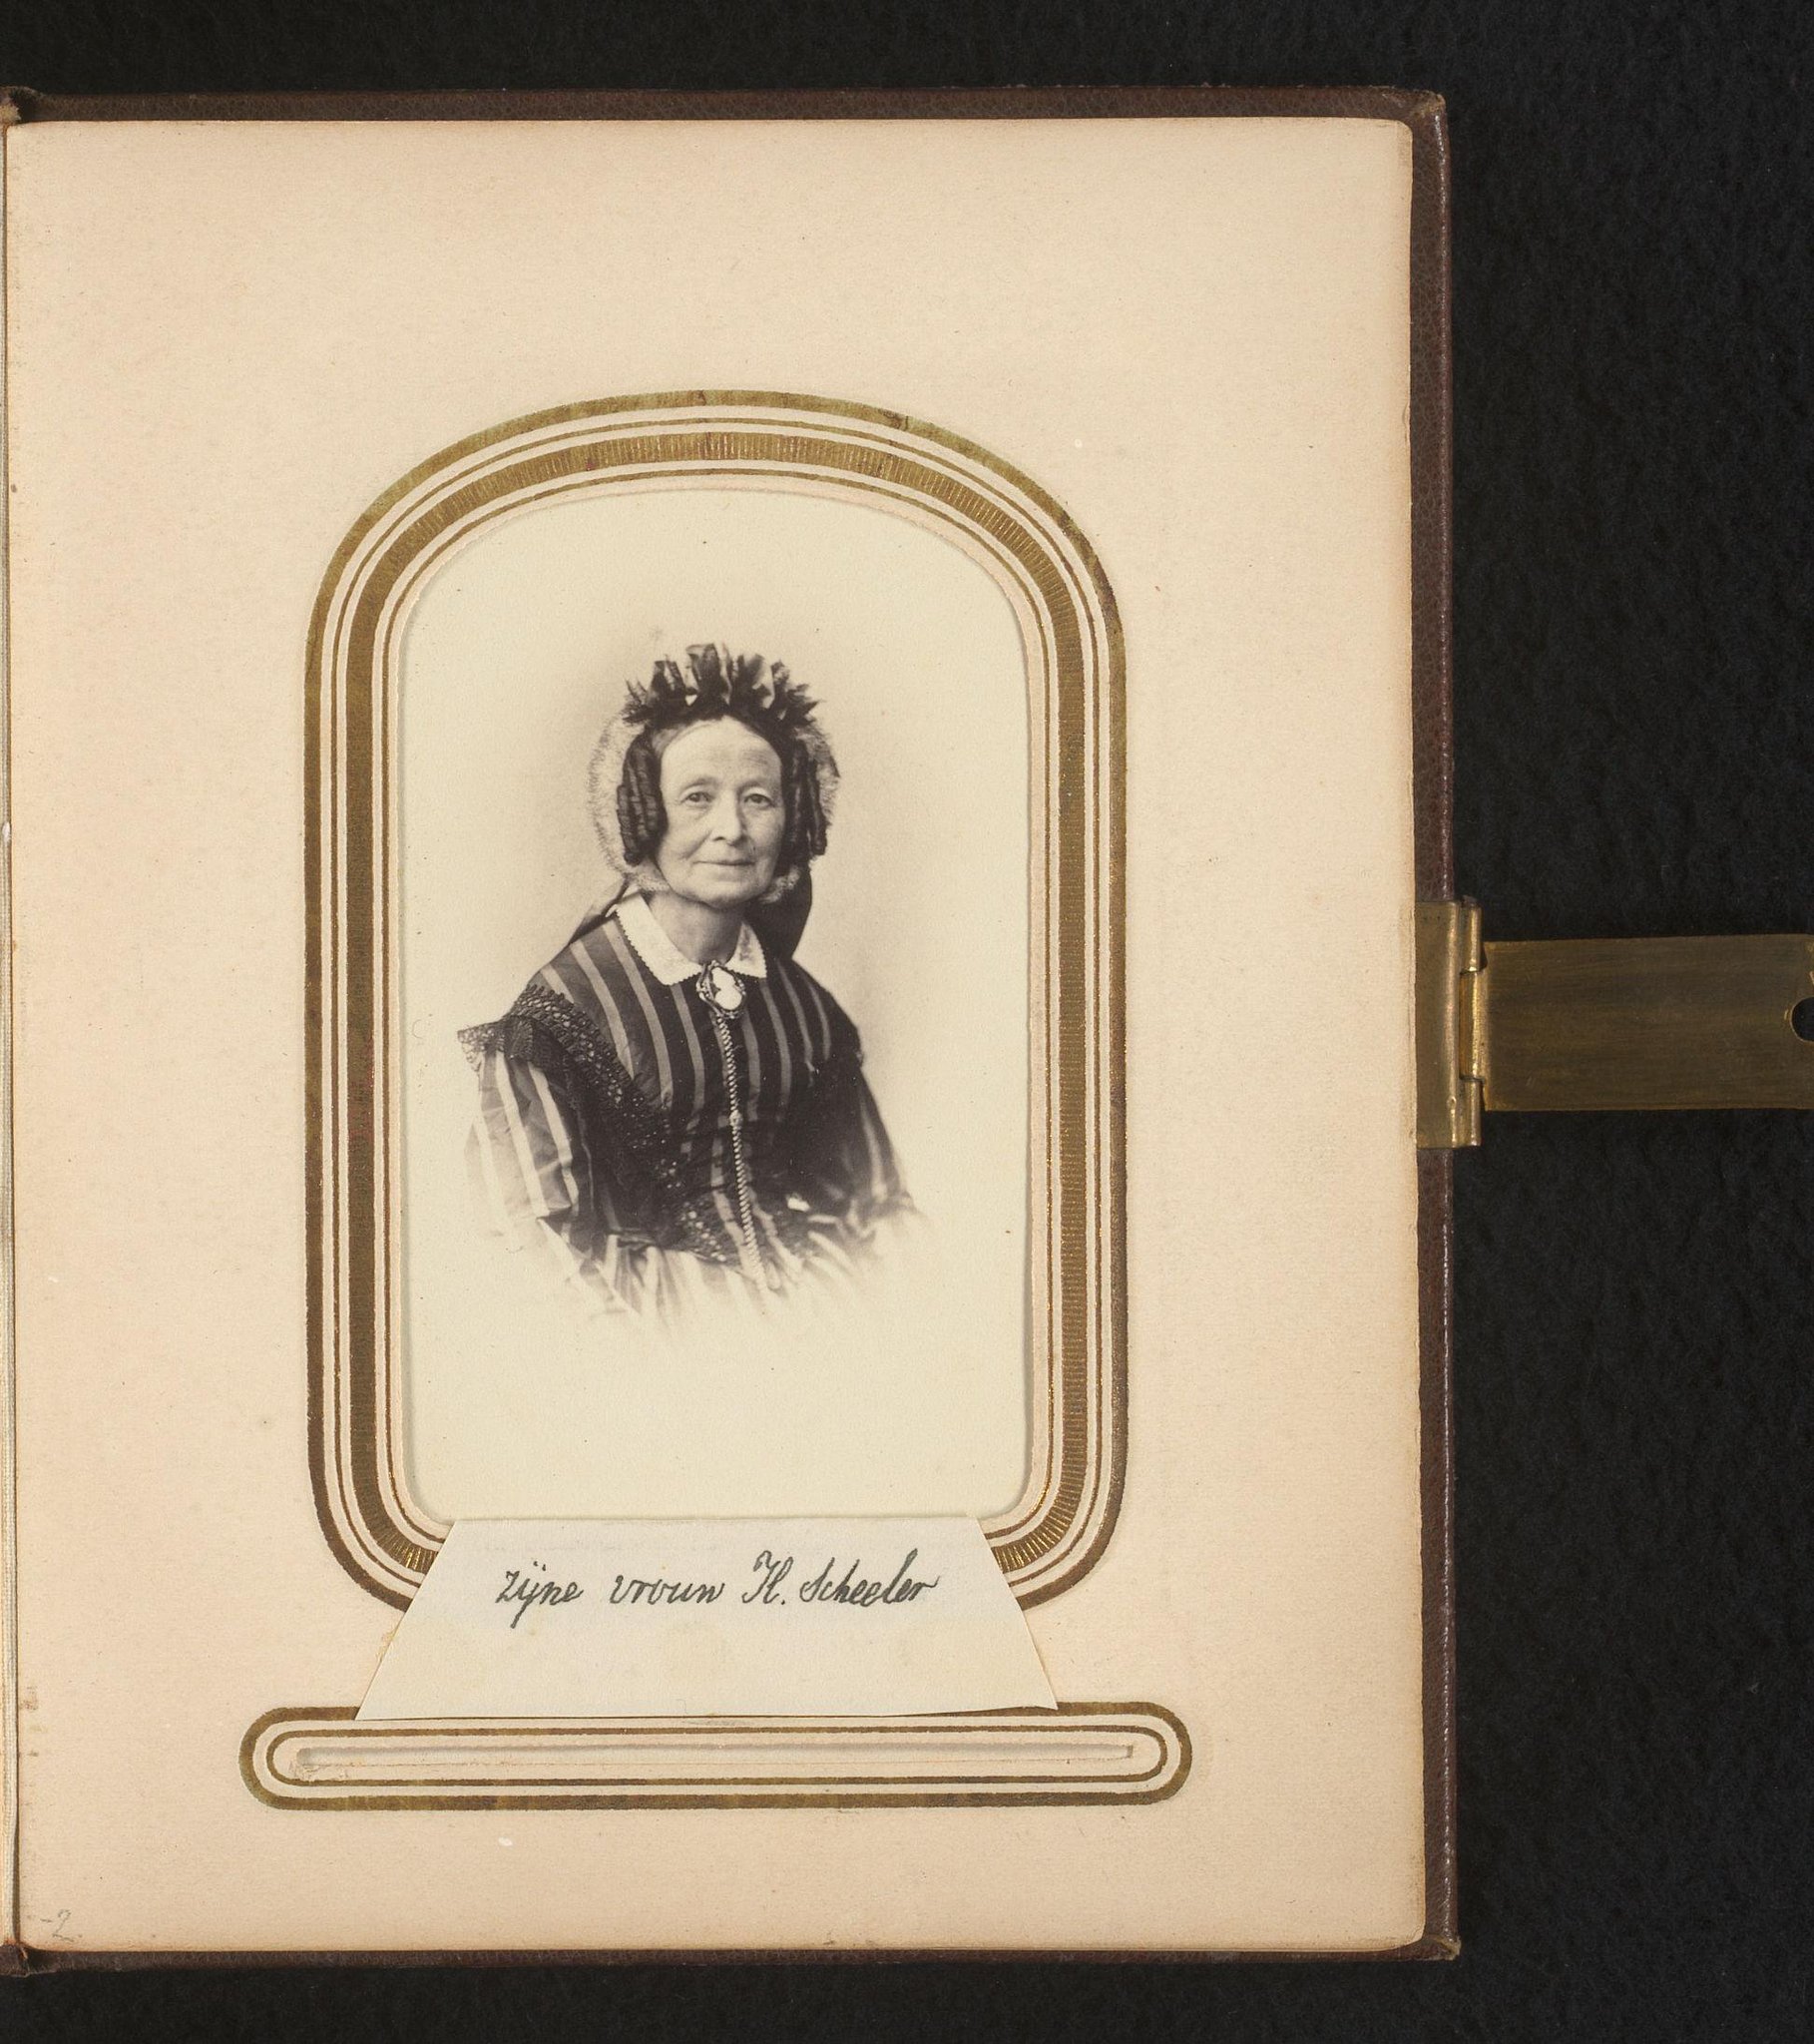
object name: carte de visite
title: Zijne vrouw H. Scheeler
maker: matthijs adolph conen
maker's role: painter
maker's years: 1833-1894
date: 1862-1865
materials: cardboard, paper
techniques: albumen print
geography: amsterdam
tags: historical persons - bb - woman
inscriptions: address: ‘Plantage Middenlaan V. 132/ Amsterdam.’